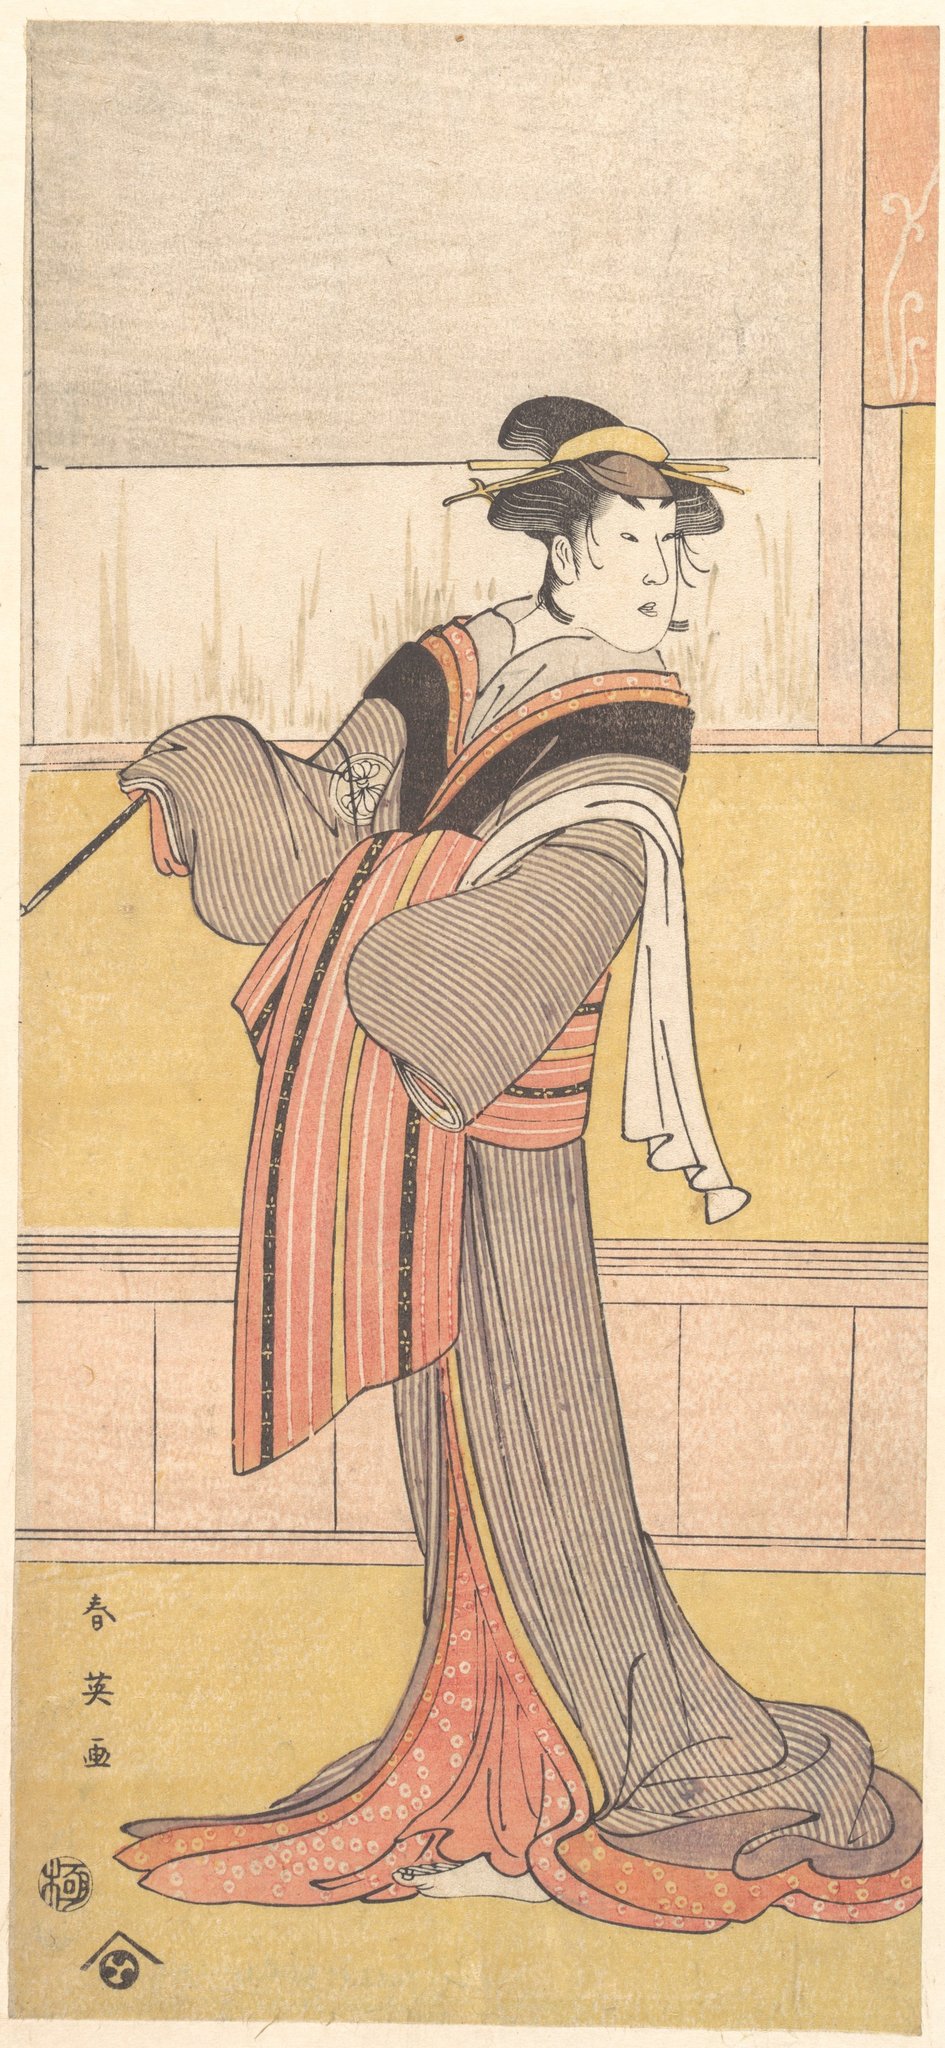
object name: print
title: Segawa Kikunojo III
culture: japanese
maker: katsukawa shun'ei 勝川春英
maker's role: artist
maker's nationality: japanese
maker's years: 1762-1819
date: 1791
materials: ink, paper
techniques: woodblock print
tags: women,actors